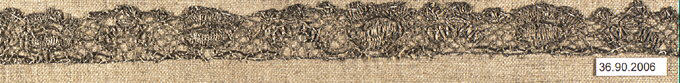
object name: piece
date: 1701-1800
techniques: lace